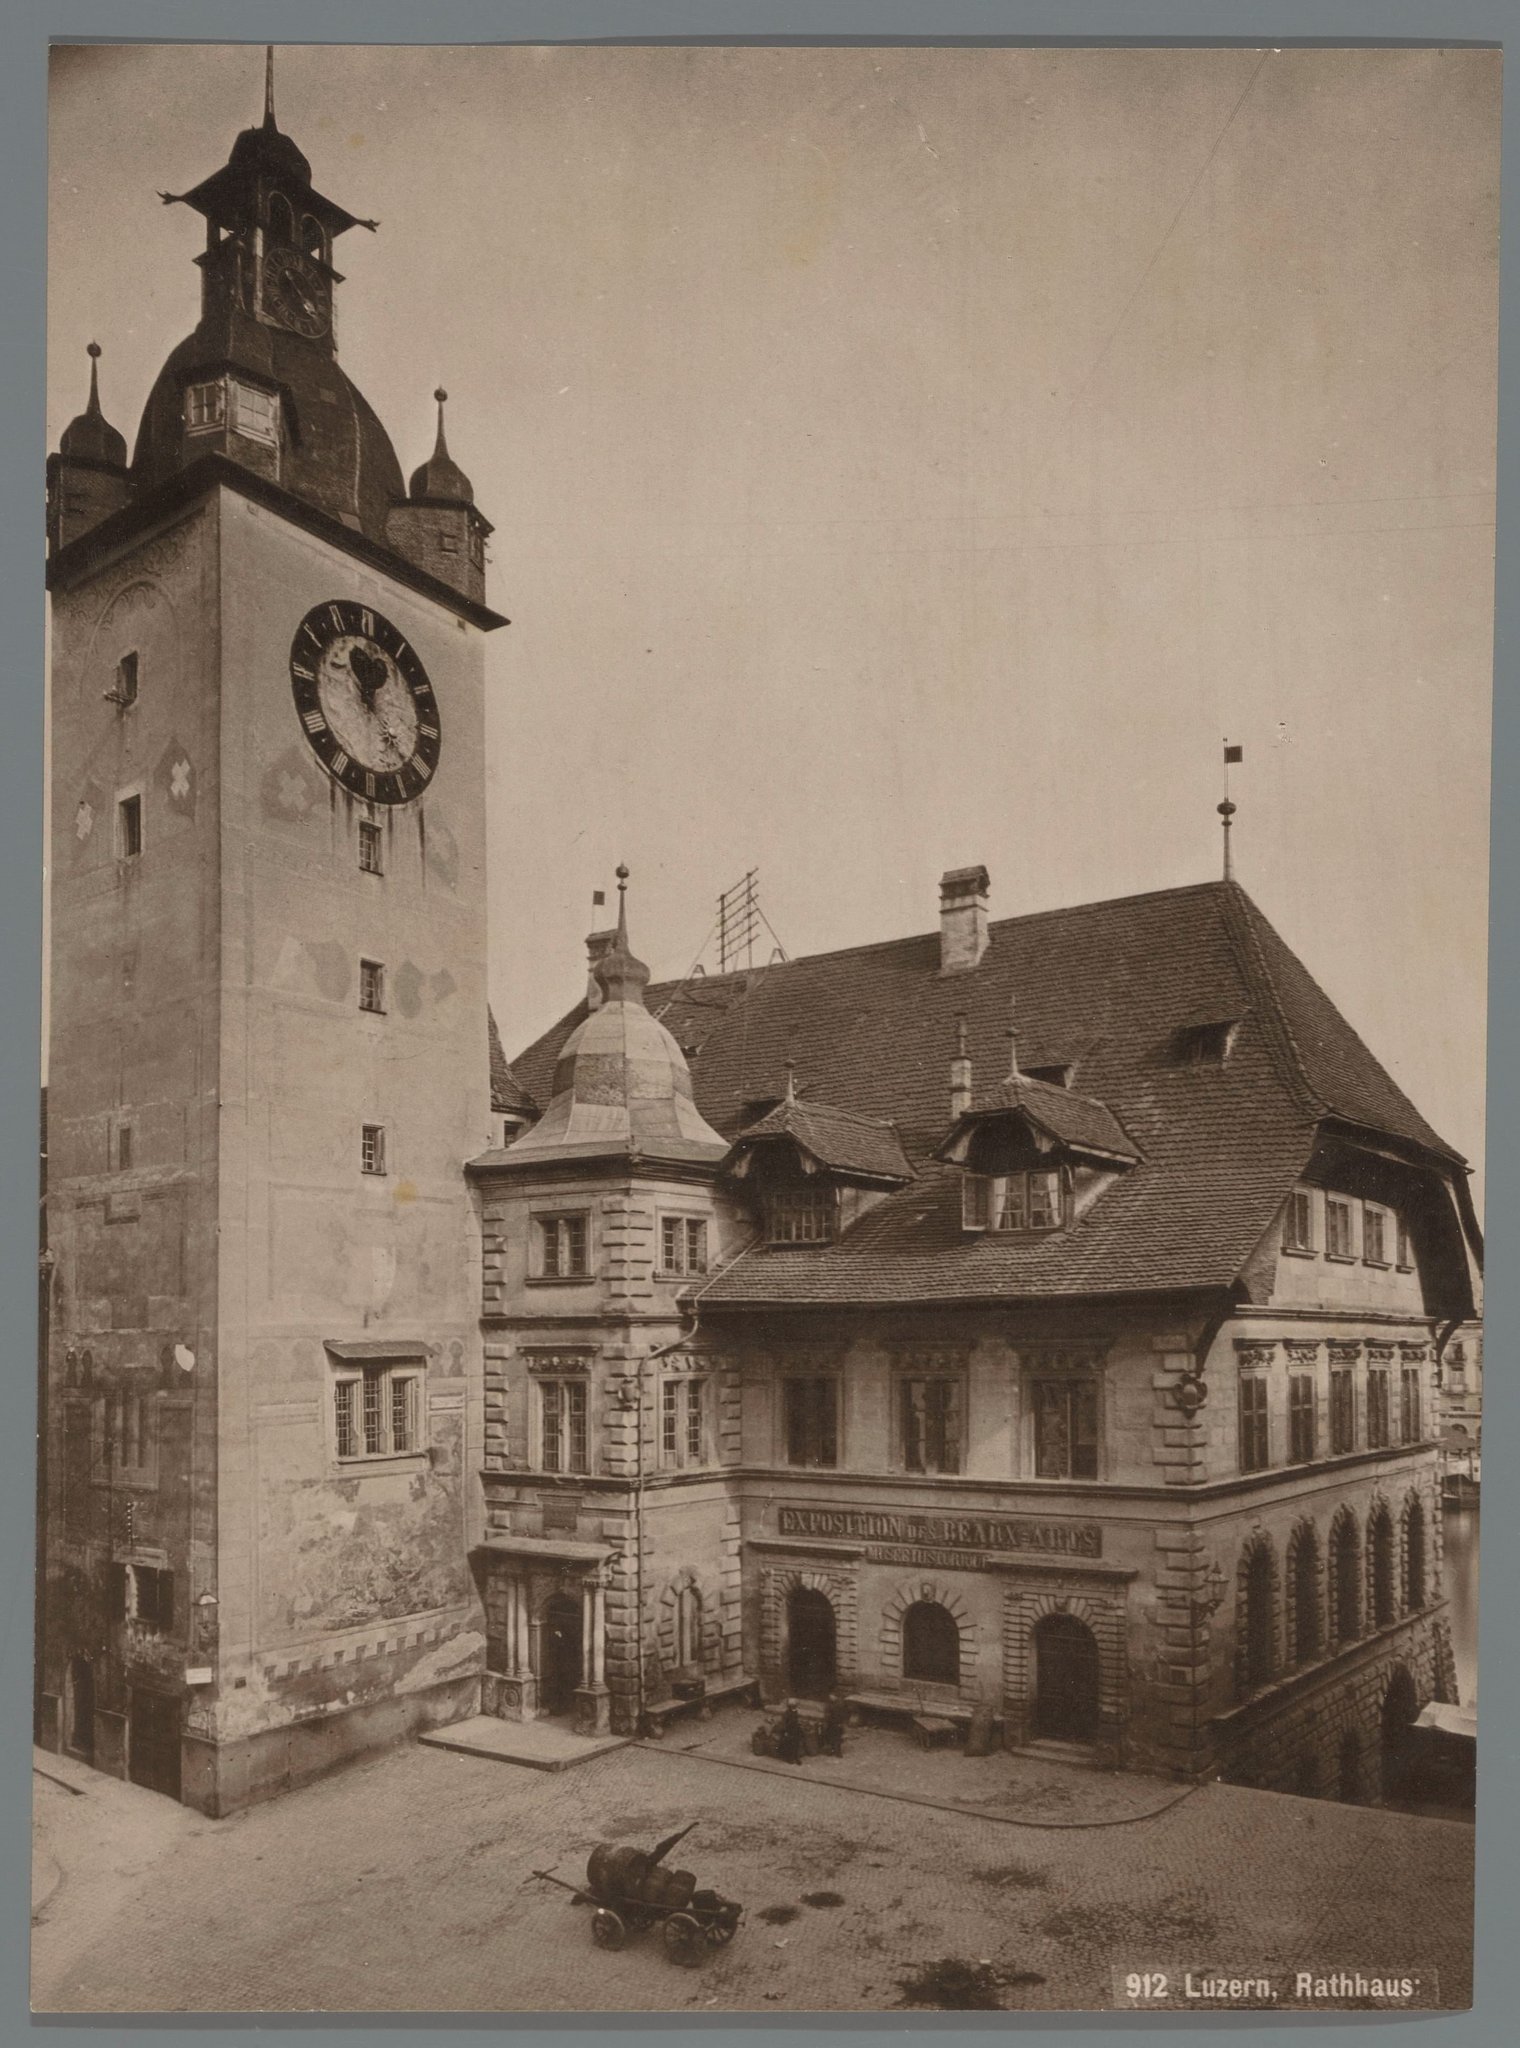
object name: photomechanical print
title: Stadhuis te Luzern met rechts het Musée Historique (de tegenwoordige Kornschütte)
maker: Anonymous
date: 1870-1890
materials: paper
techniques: photograph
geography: lucerne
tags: townhall, permanent exhibition, museum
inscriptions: number: ‘912’